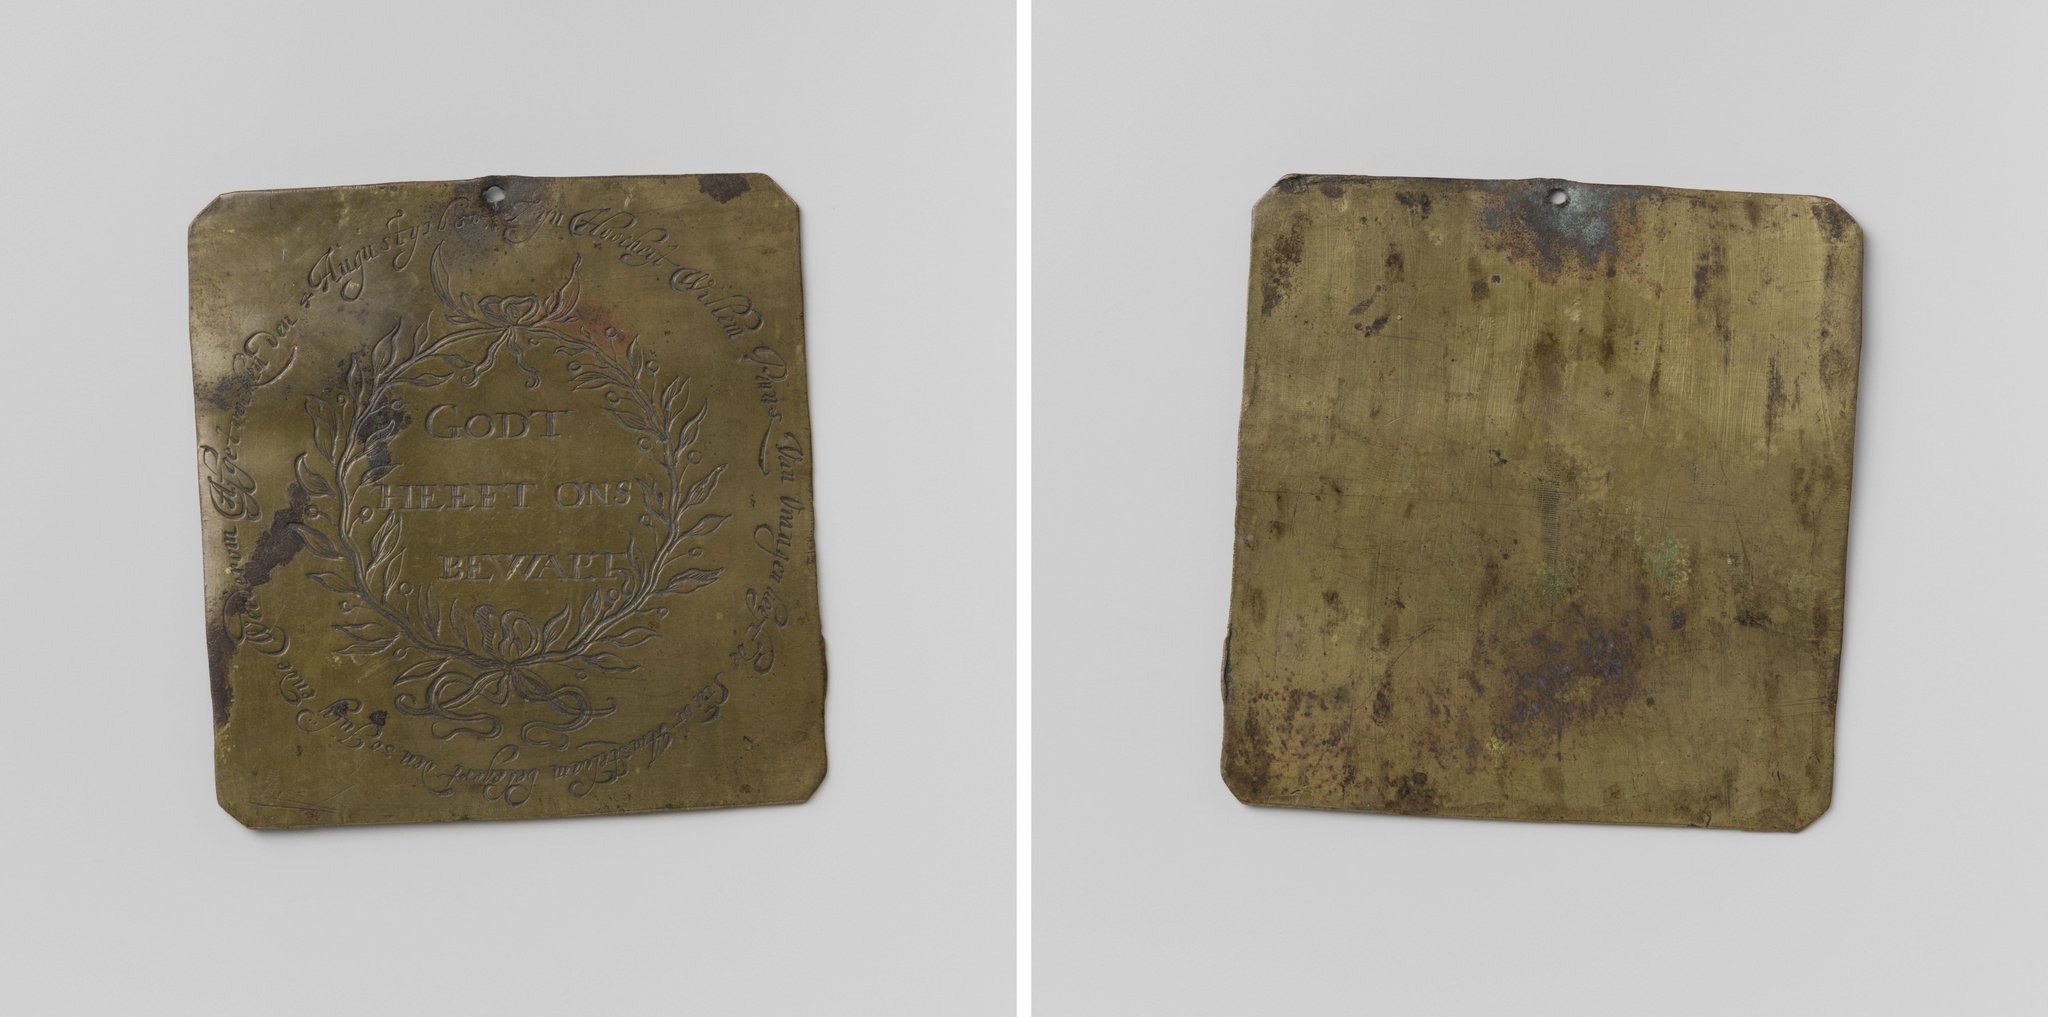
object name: plaque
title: Beleg van Amsterdam door Willem II, prins van Oranje-Nassau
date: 1650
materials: copper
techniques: engraving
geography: netherlands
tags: william ii (prince of orange), amsterdam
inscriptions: inscription: ‘Godt heeft ons bewart’, circumscription: ‘Zijn Hoocheijt Willem, Prins van Orangen heeft de stadt Amsteldam belegert den 30 July ende wederom afgetrocken den 4 Augusty 1650’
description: Eenzijdige, vierkante plaquette met afgestompte hoeken en gat erin. Voorzijde: opschrift binnen lauwerkrans en omschrift. Keerzijde: blanco.